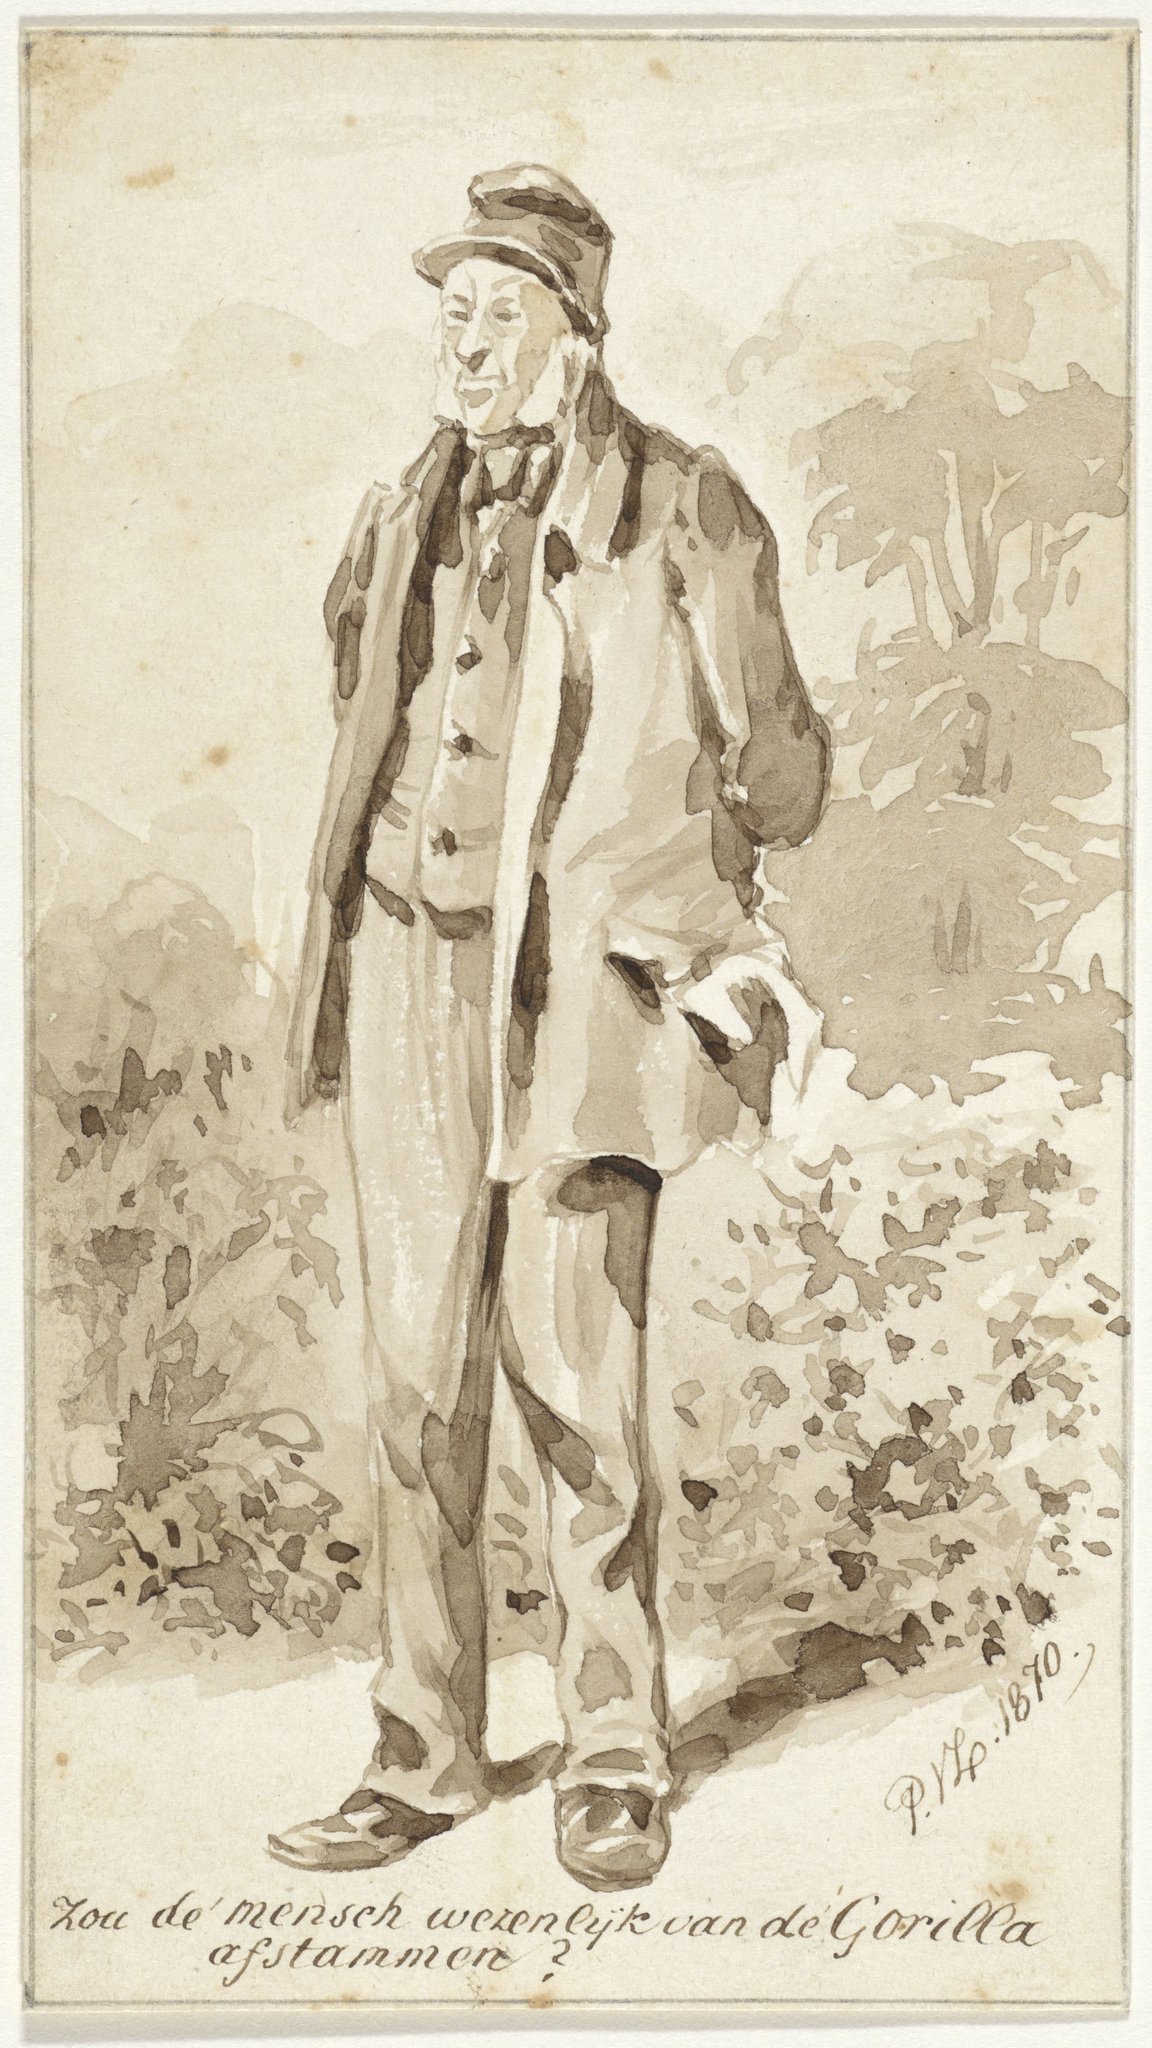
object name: drawing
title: Staande man met bakkebaarden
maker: pieter van loon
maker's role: draughtsman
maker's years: 1801-1873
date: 1870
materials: paper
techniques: brush, pen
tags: caricatures (human types)